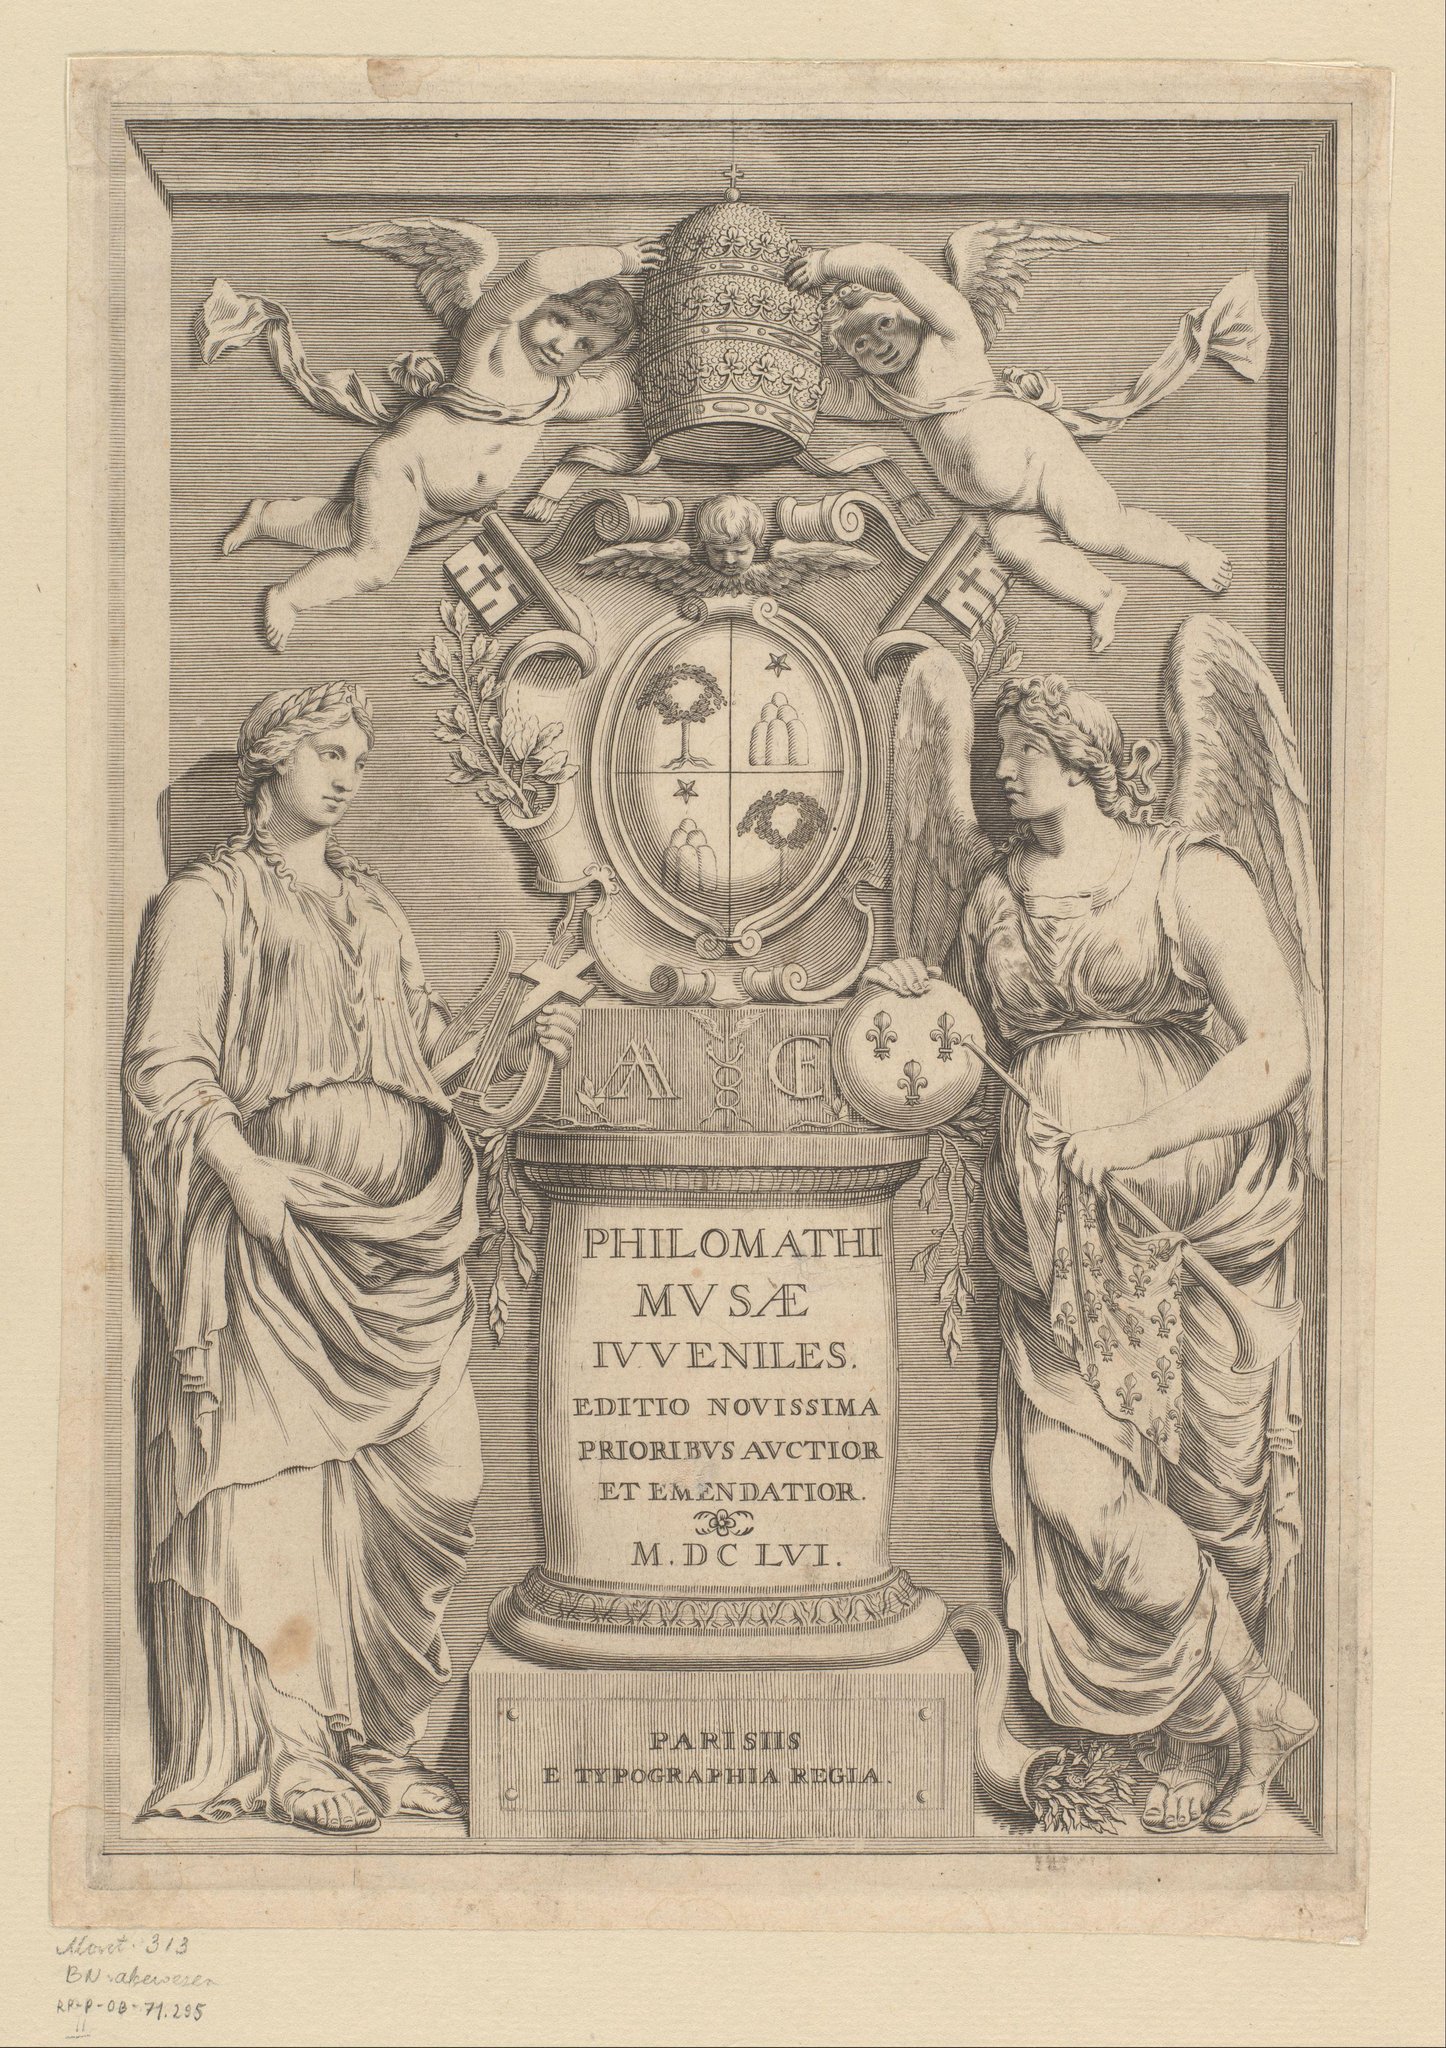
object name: titelblad, titelpagina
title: Titelpagina voor: Paus Alexander VII, Philomathi musae ivveniles, 1656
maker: claude mellan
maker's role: draughtsman, print maker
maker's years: 1598-1688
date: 1608-1688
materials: paper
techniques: engraving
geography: paris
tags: insignia of the pope, e.g. tiara, armorial bearing, heraldry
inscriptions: collector's mark: Lugt 240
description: Titelpagina voor: Paus Alexander VII. Philomathi musae ivveniles. Parijs: Imprimerie Royale, 1656.